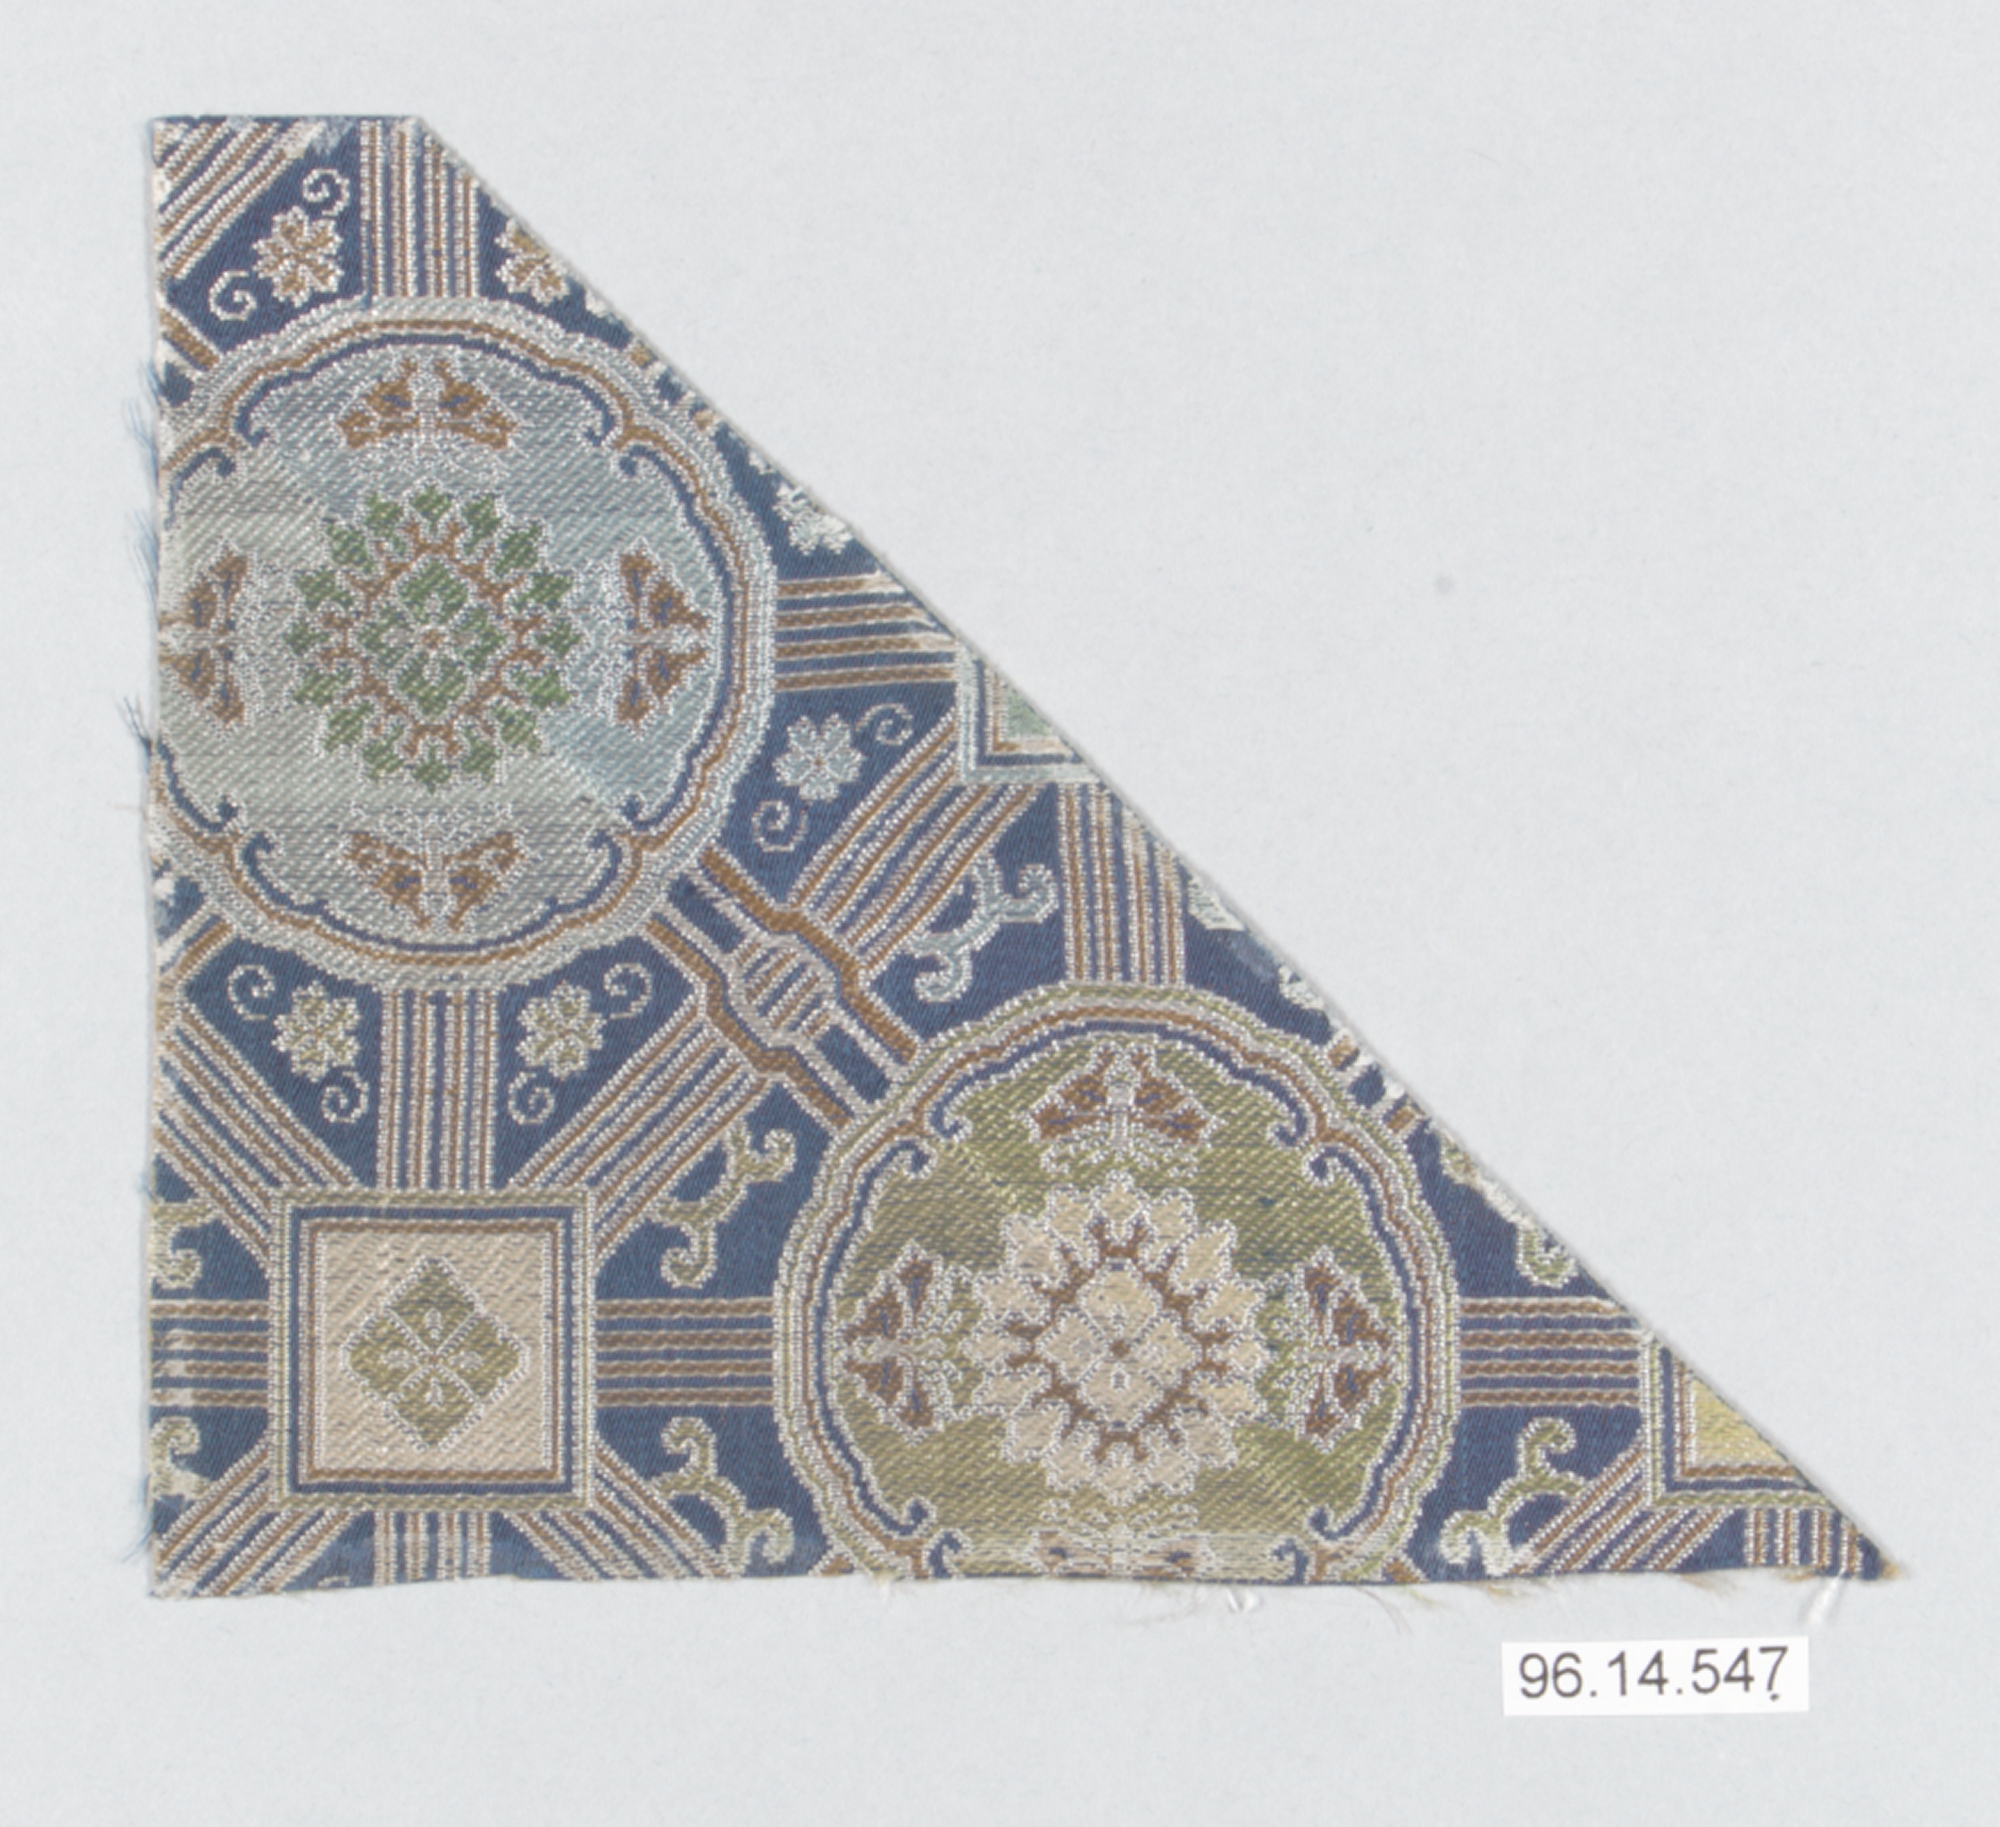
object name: piece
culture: japanese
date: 1701-1900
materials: silk